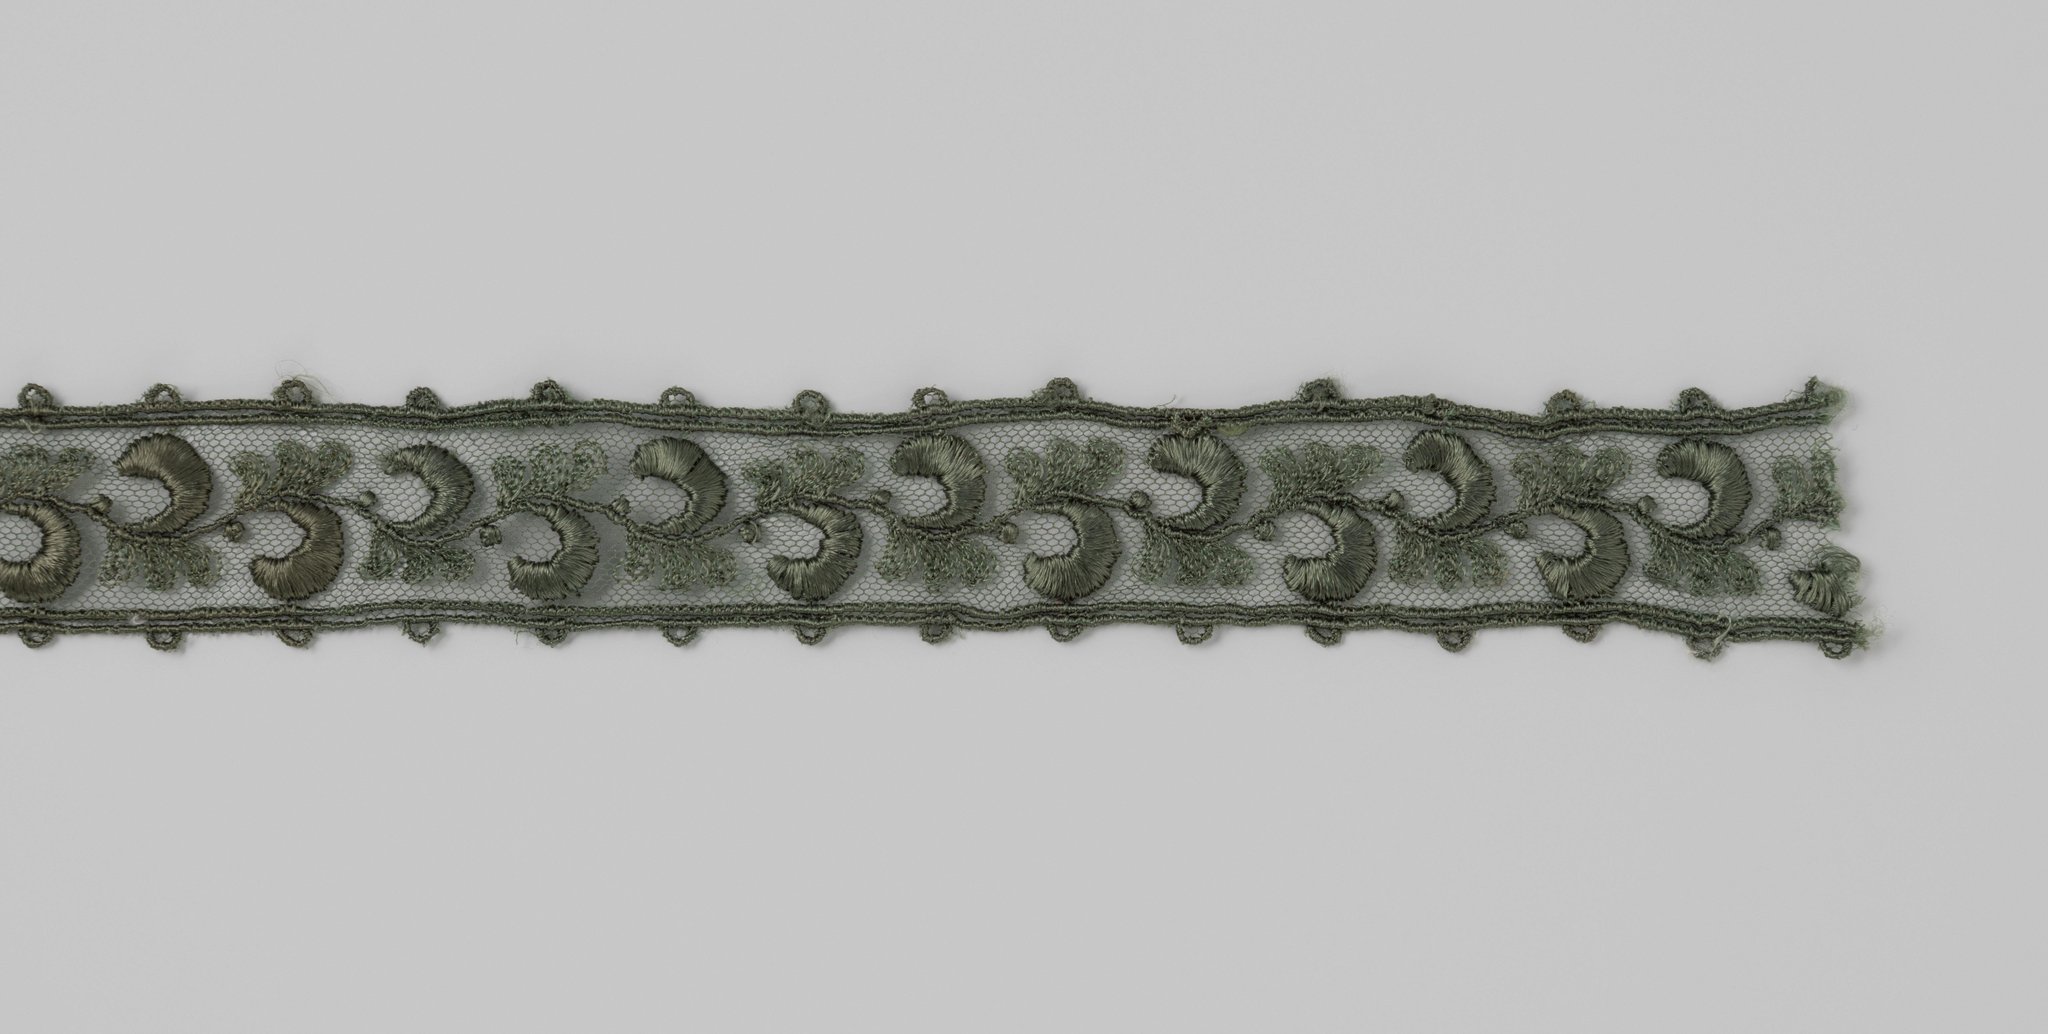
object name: braid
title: Passement, groene tule met zijdeborduursel. Kant met slingerende rand met bladwerk en voluten in reliëf.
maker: Anonymous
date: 1900-1925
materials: textile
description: Passement van groene tule met groen zijde geborduurd. Machinale kant van groene kunstzijde met rechte lijsten, waartussen een slingerende rand loopt met bladeren in doorstop en voluten in diep reliëf.